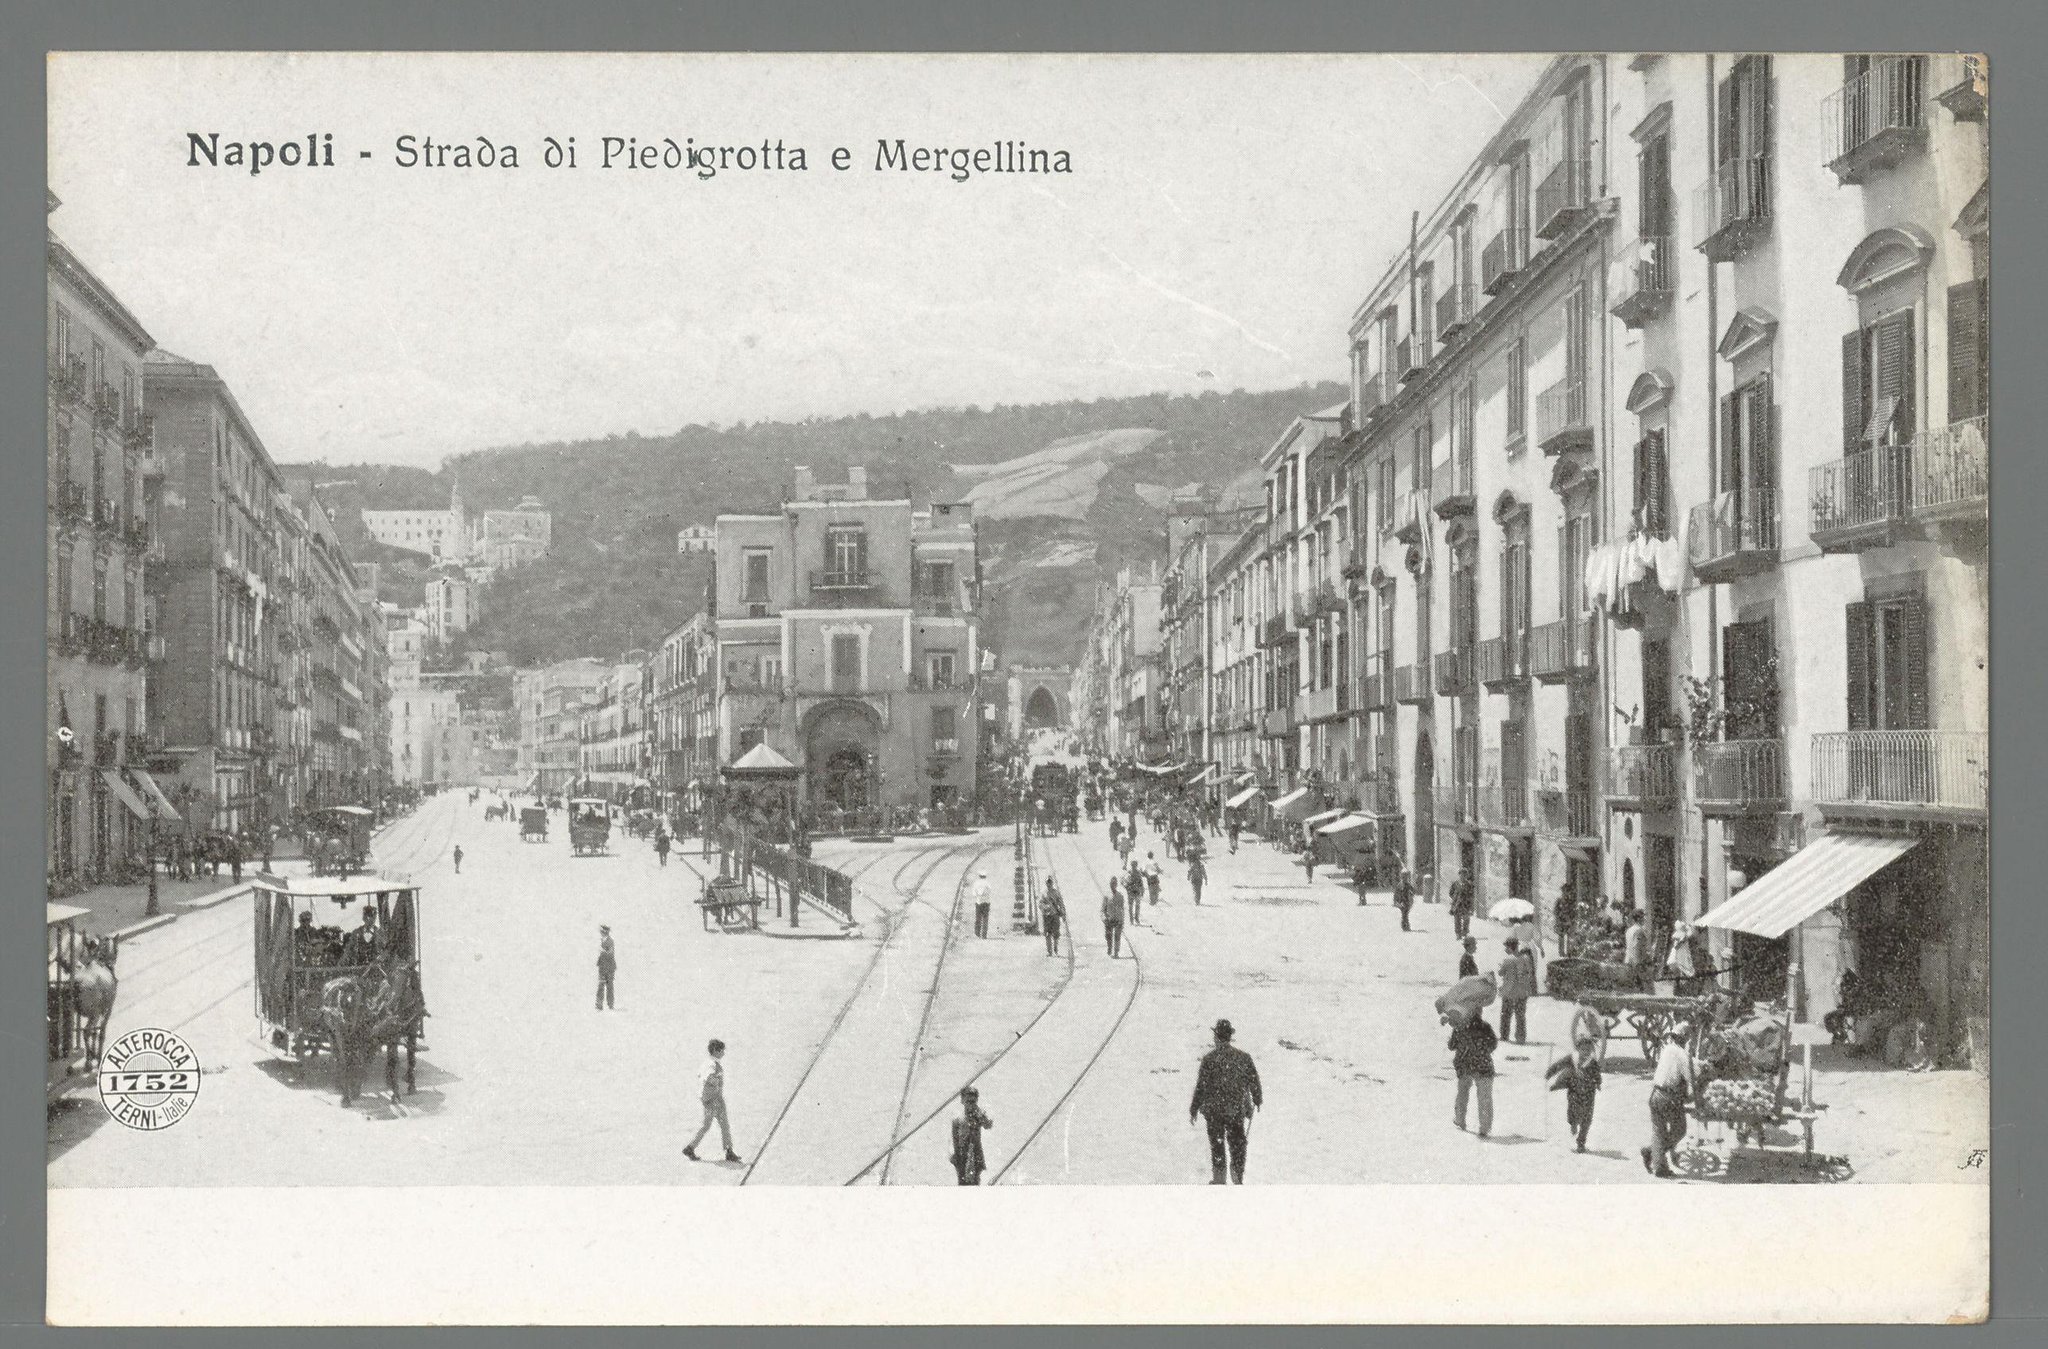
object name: photomechanical print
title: Napoli. Strada di Piedigrotta e Mergellina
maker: Anonymous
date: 1906-1910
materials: cardboard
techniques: autotype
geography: terni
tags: tramway, tram, four-wheeled, animal-drawn vehicle, e.g.: cab, carriage, coach, city-view, and landscape with man-made constructions (+ city(-scape) with figures, staffage)